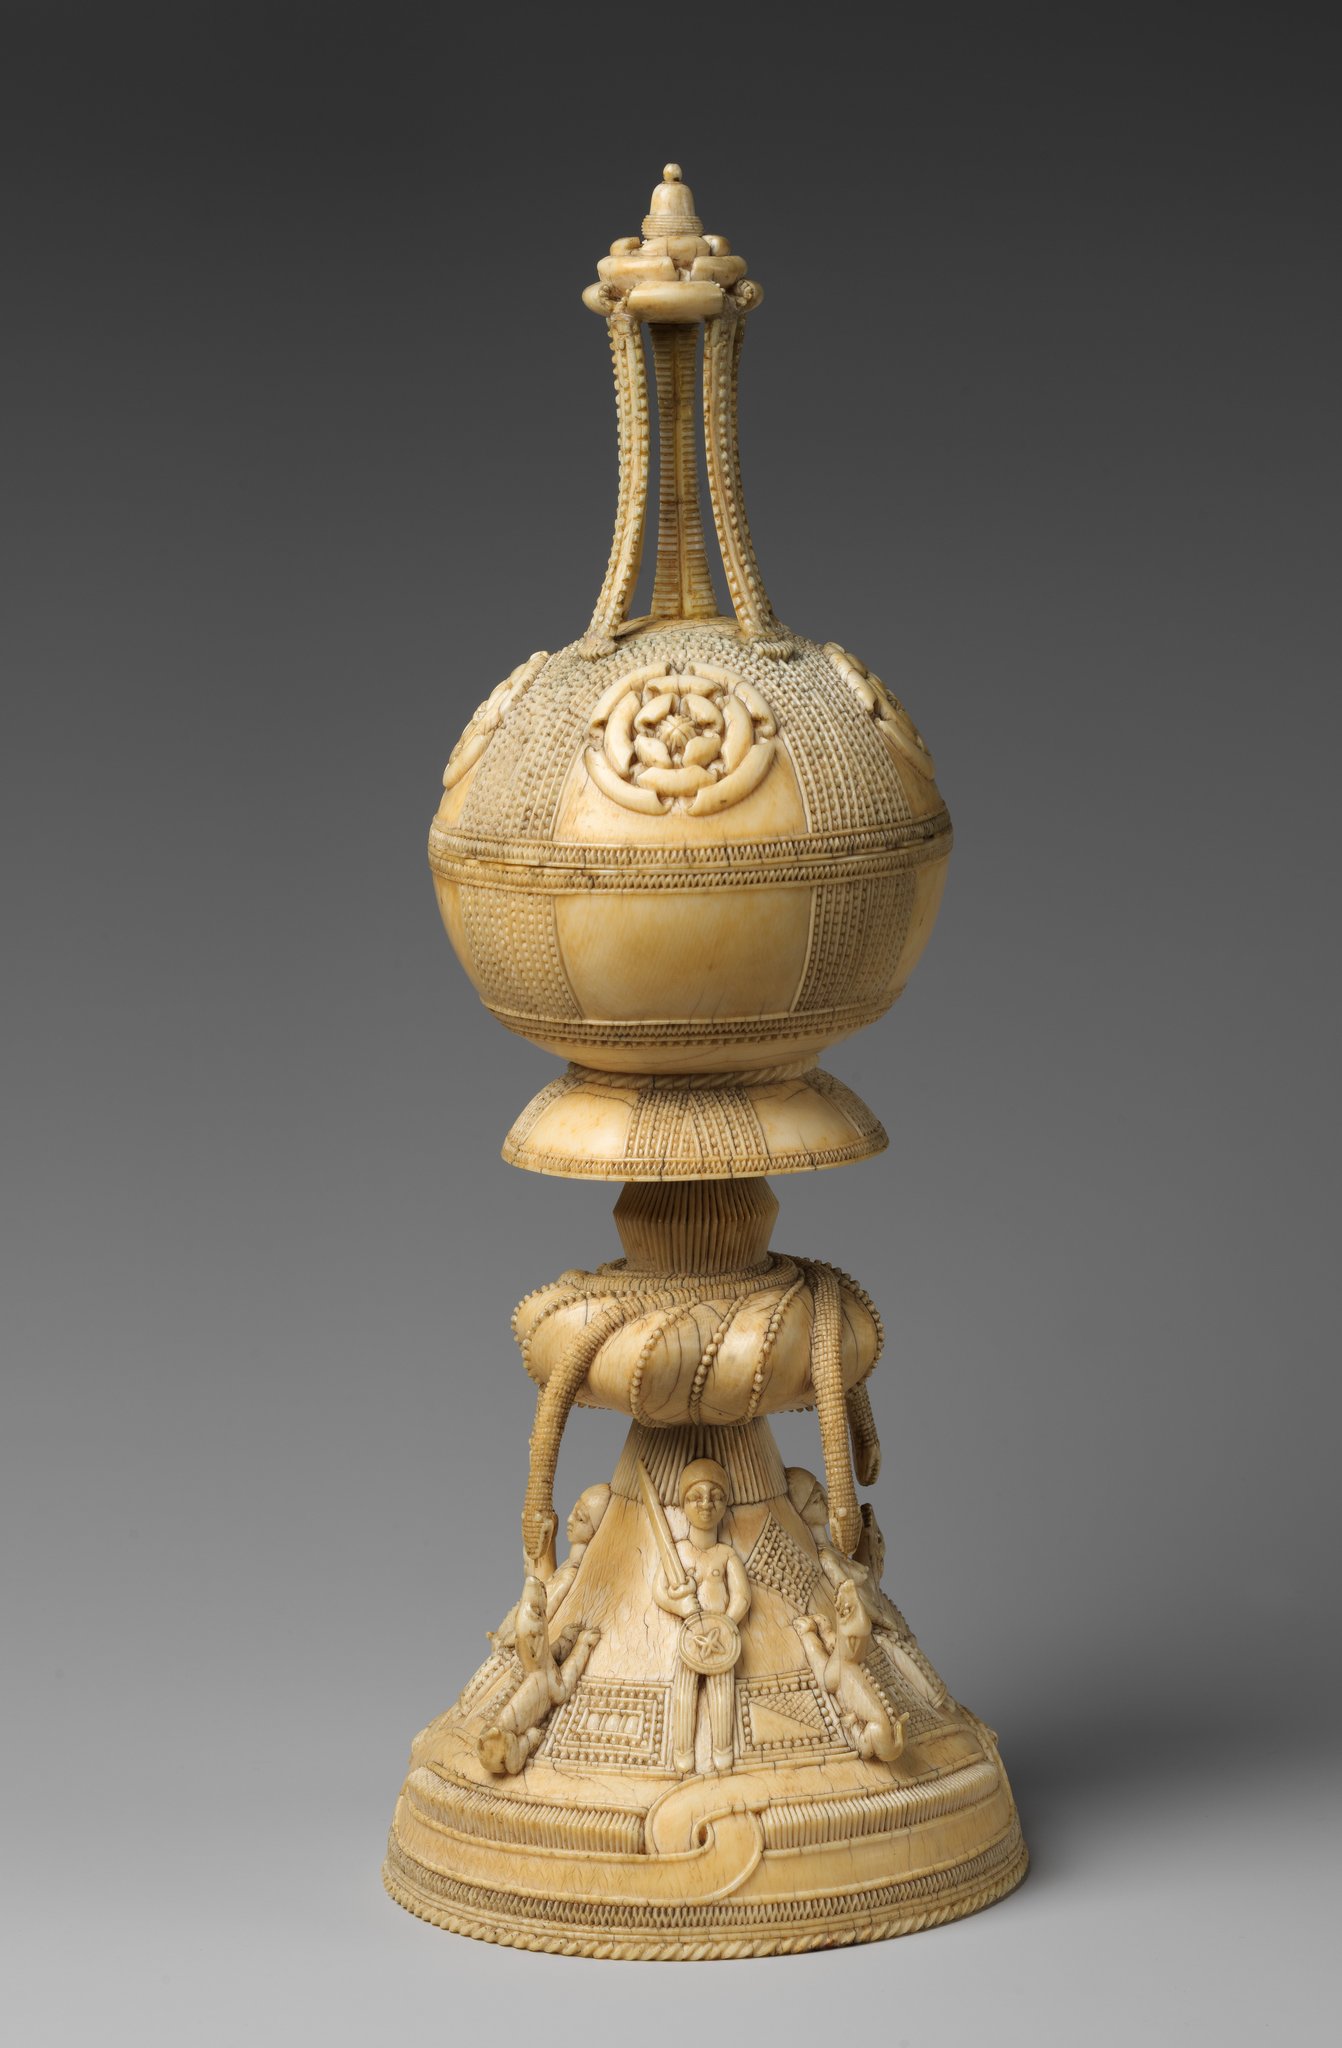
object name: saltcellar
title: Lidded saltcellar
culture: bullom or temne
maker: temne or bullom artist(s)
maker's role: artist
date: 1490-1530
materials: ivory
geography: sierra leone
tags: men,women,dogs,snakes